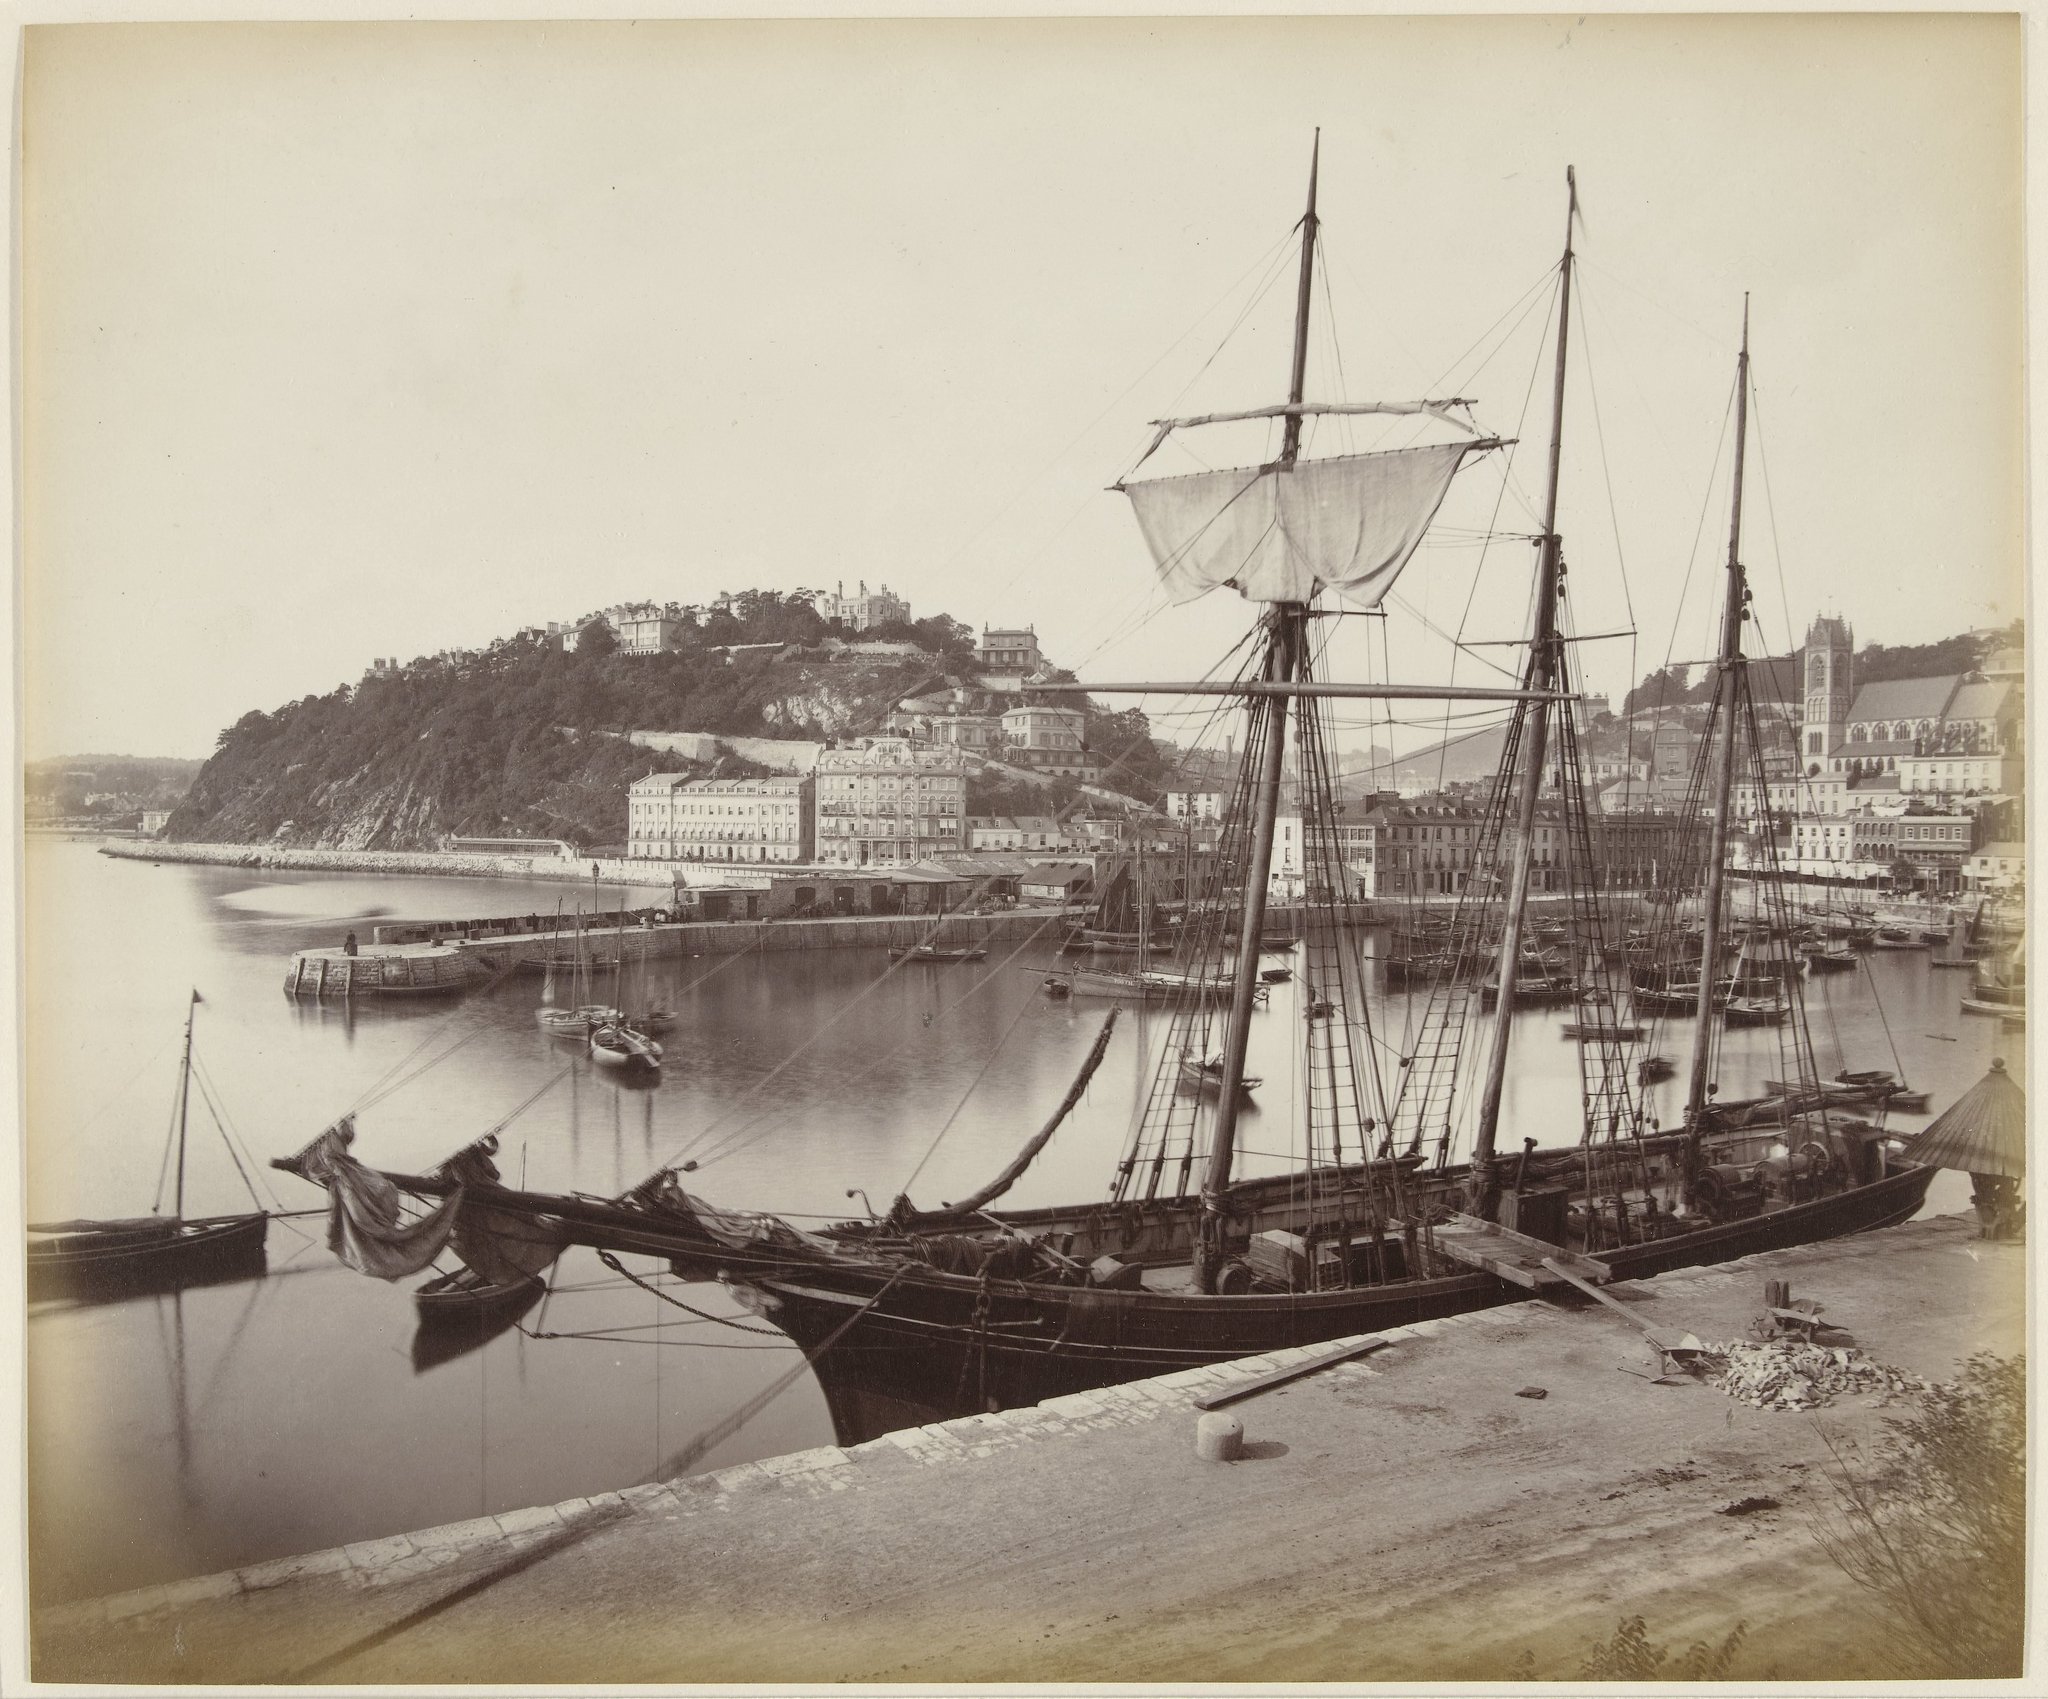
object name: photograph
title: Schip in de haven van Torquay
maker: carl frederick musans norman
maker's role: publisher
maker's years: 1841-1927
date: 1880-1905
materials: paper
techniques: albumen print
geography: great britain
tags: harbour